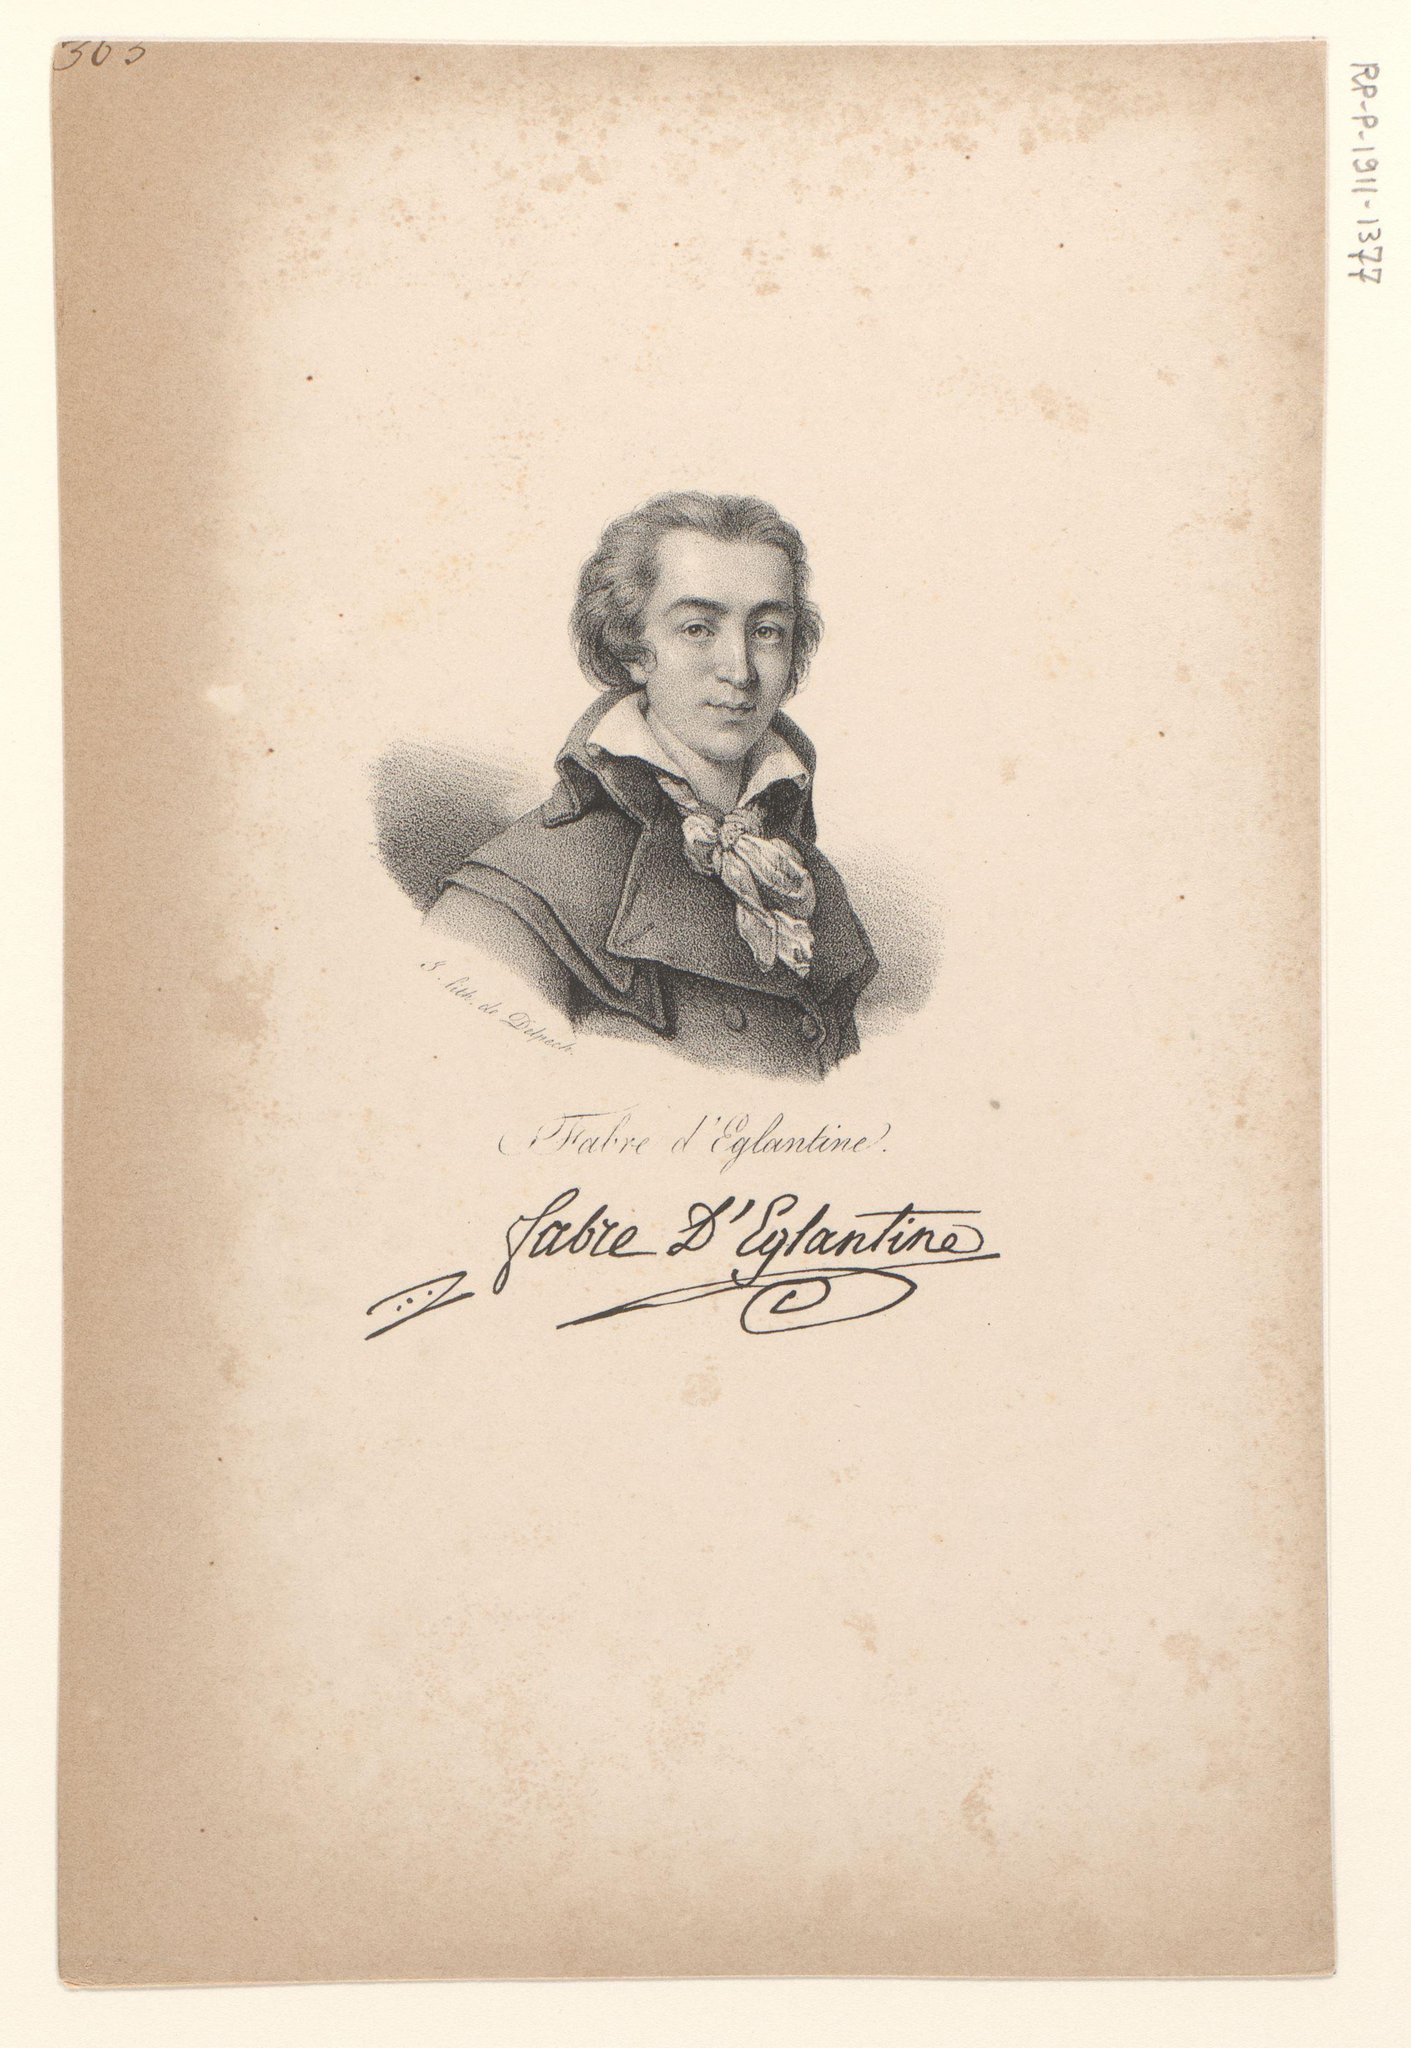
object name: print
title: Portret van Fabre d'Églantine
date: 1818-1842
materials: paper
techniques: lithograph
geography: paris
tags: paris, politician, historical persons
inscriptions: collector's mark: Lugt 2228a